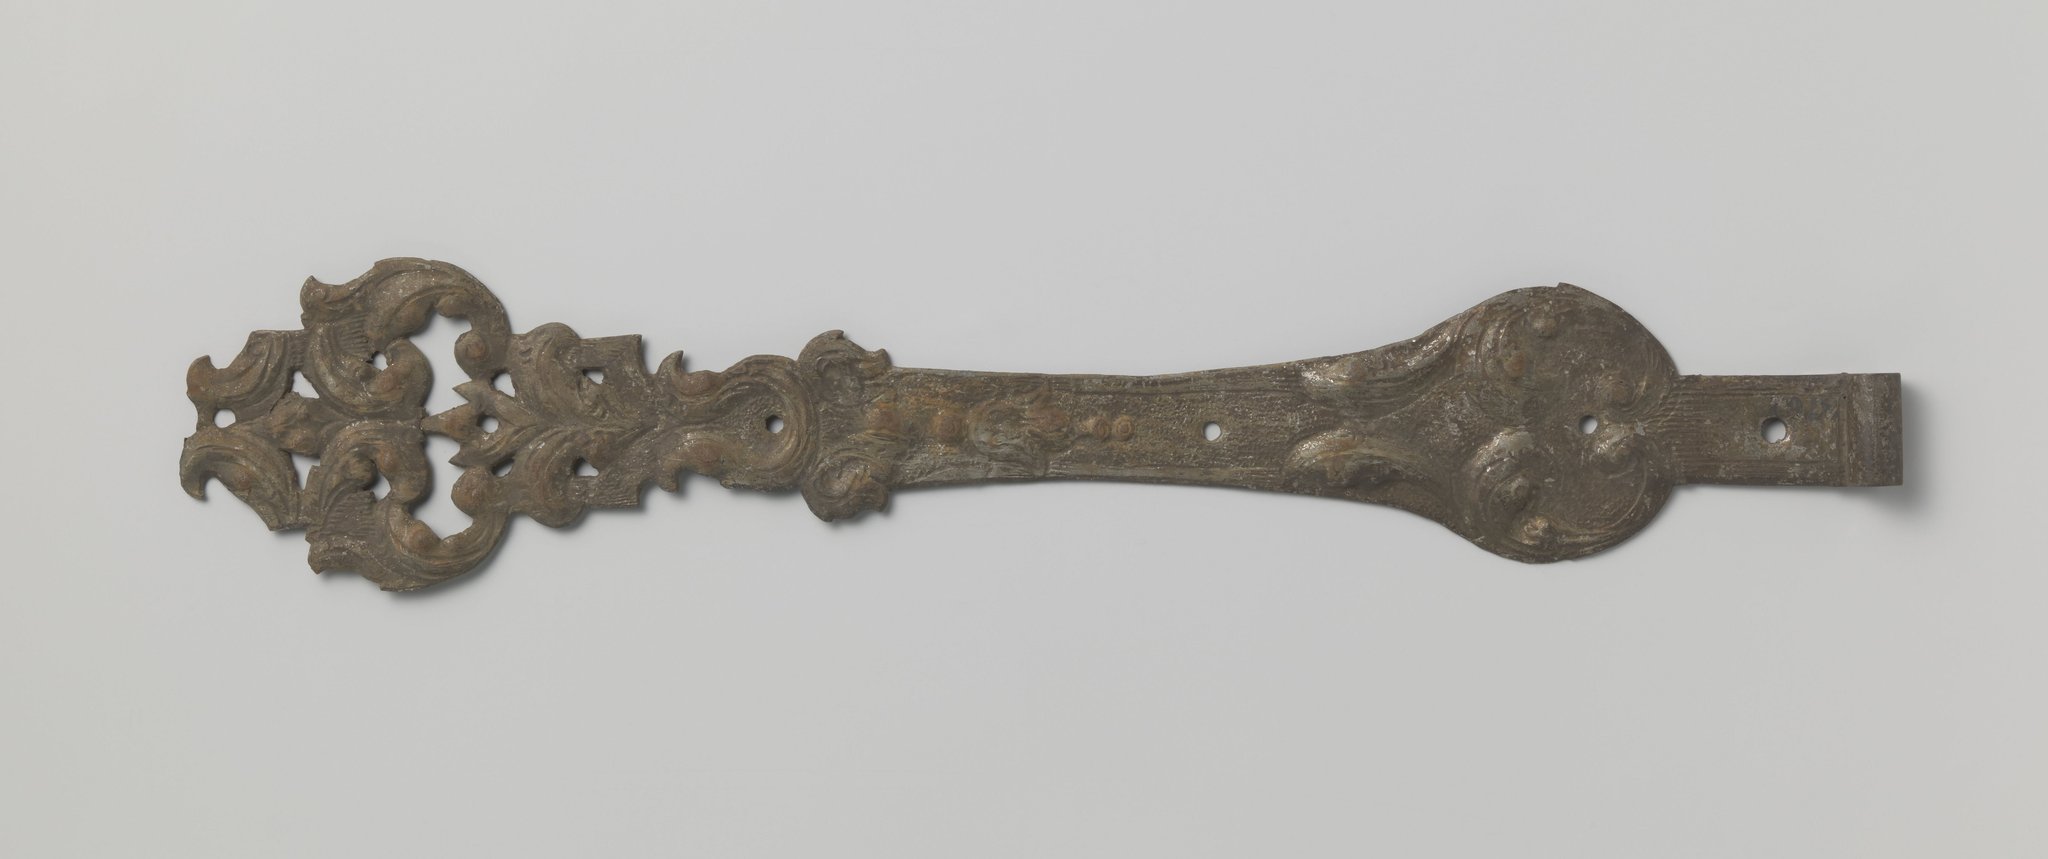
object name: hengsel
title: Hengsel met drijfwerk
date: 1400-1950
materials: iron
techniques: repoussé